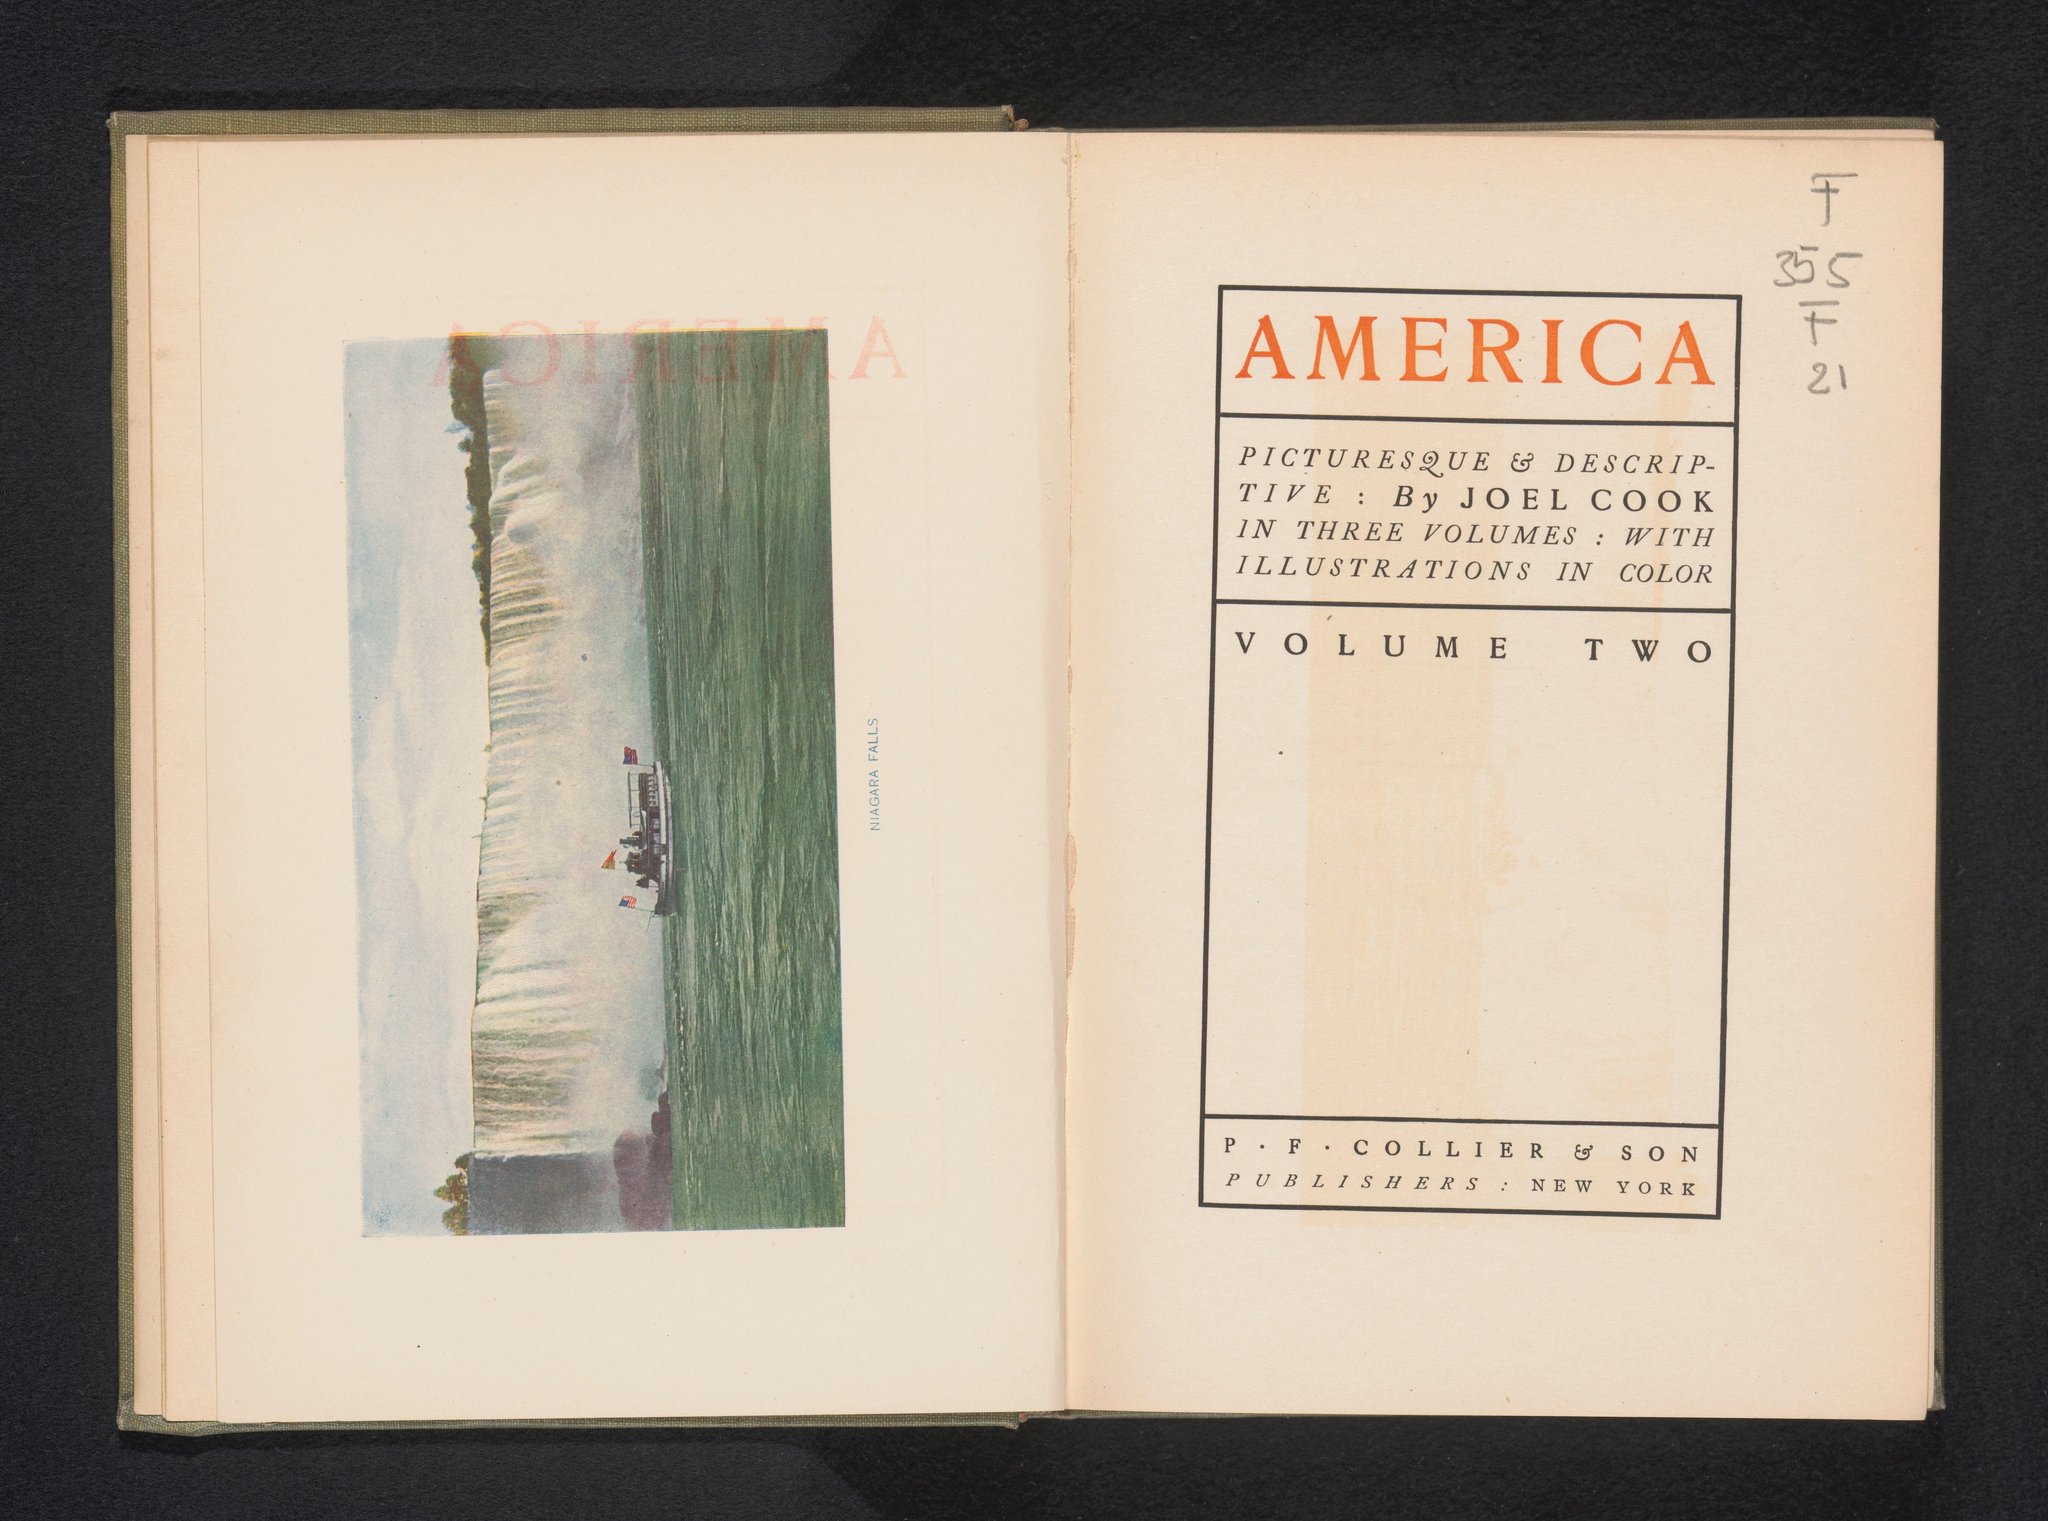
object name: book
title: America : picturesque and descriptive volume two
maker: joel cook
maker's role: politician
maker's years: 1842-1910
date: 1900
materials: cardboard, linen, paper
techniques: printing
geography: new york city